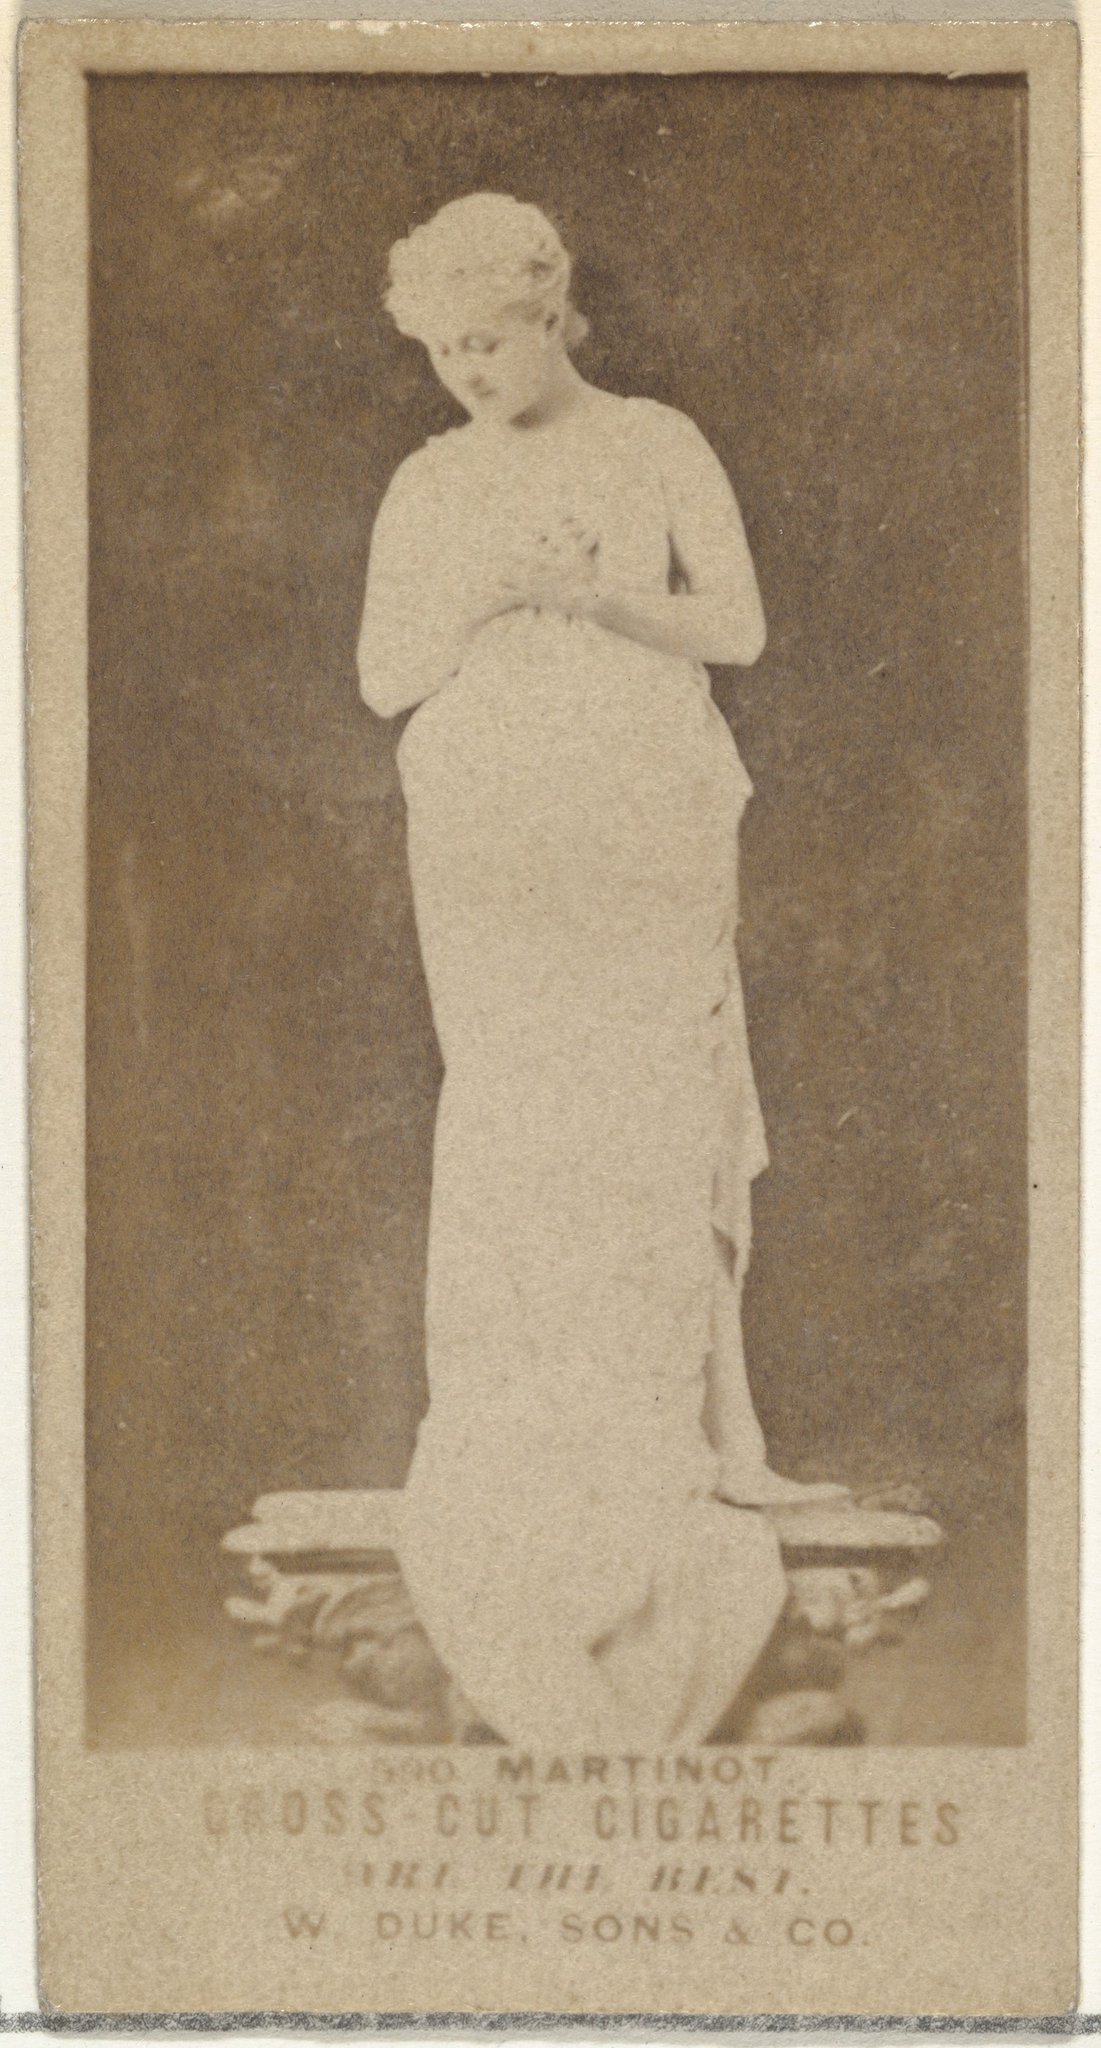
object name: photograph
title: Card Number 590, Sadie Martinot, from the Actors and Actresses series (N145-3) issued by Duke Sons & Co. to promote Cross Cut Cigarettes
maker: w. duke, sons & co.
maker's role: publisher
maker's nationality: american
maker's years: 1870-1920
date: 1880-1889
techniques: albumen silver print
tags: portraits,women,actresses